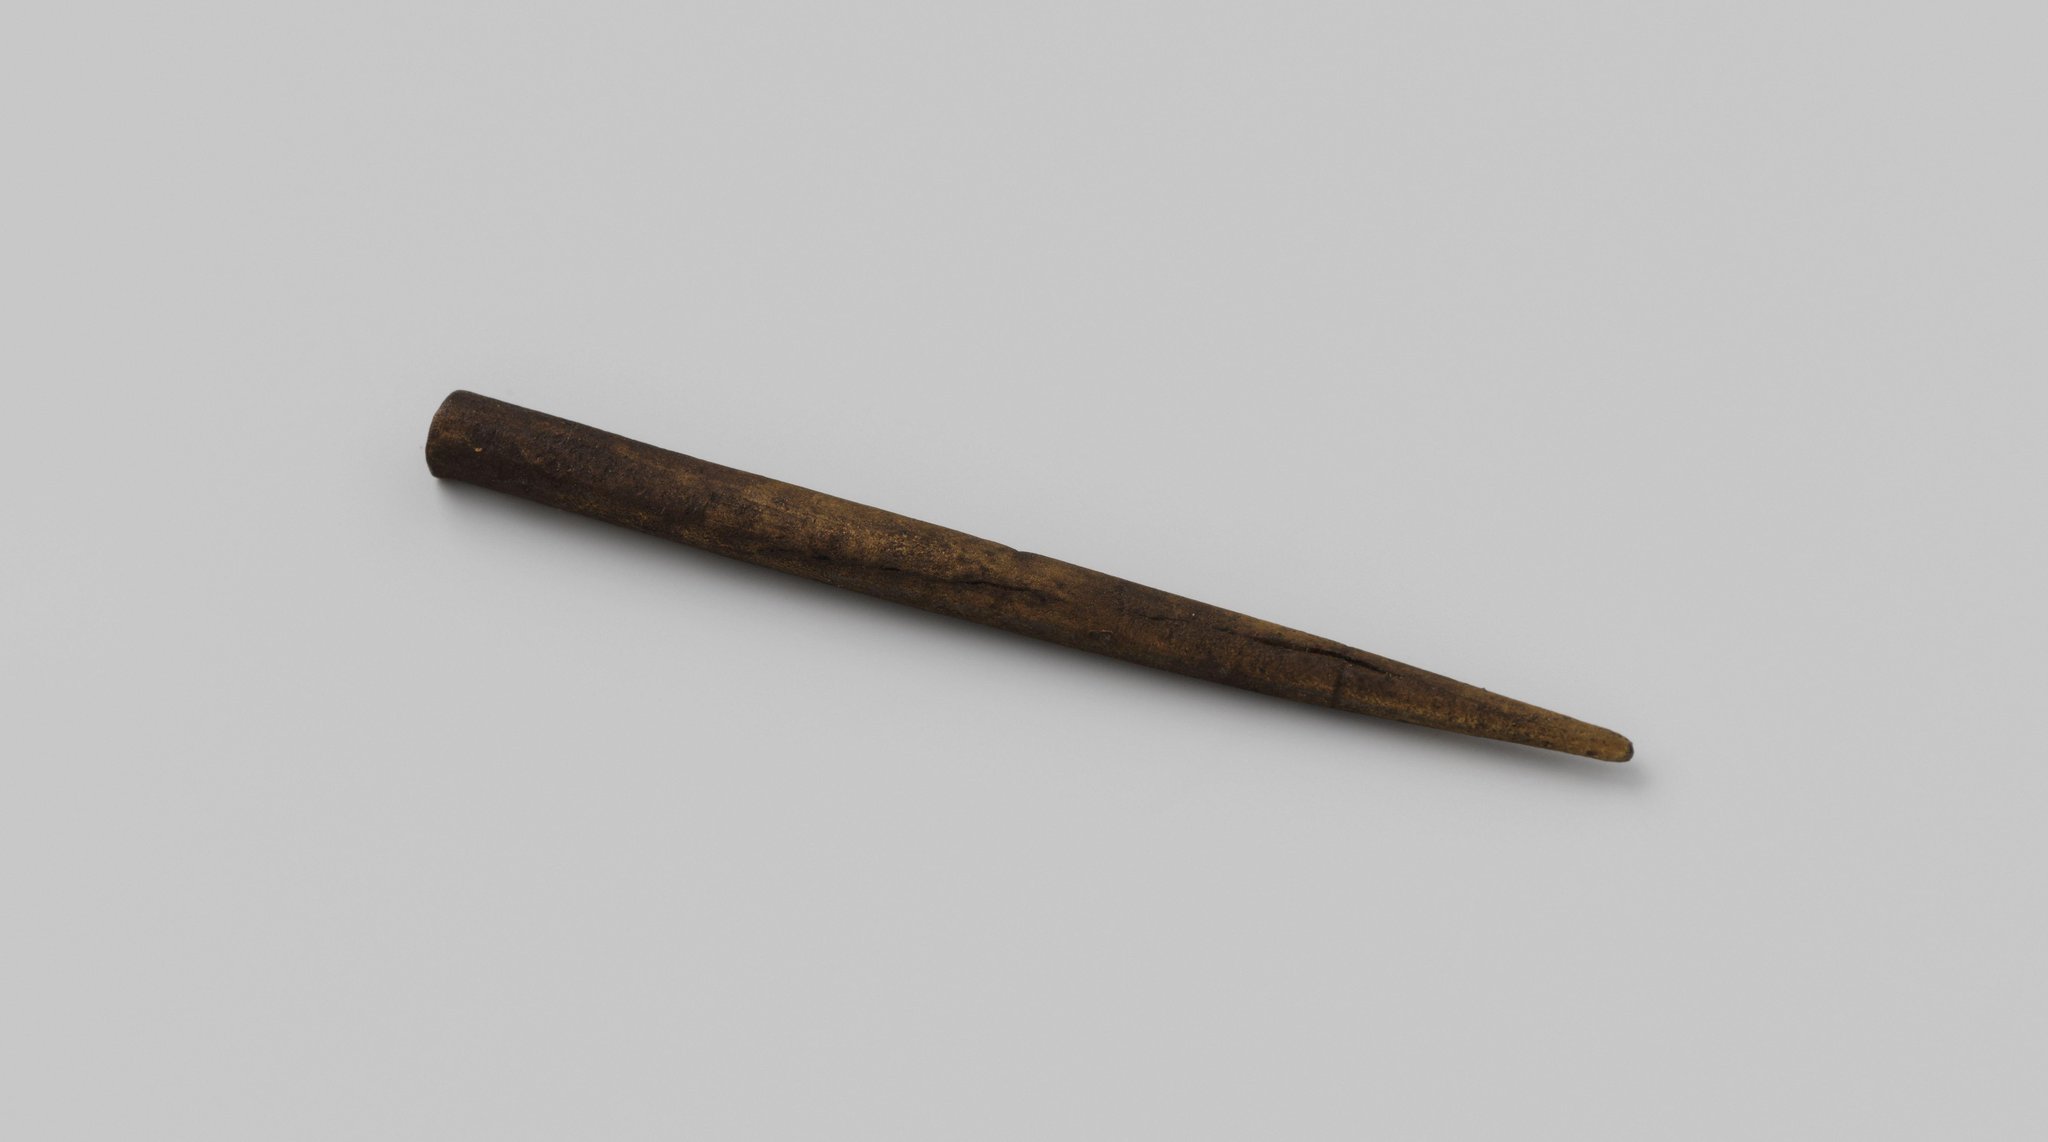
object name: fragment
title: Gepunt onderdeel uit het wrak van de Oost-Indiëvaarder Hollandia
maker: Anonymous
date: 1700-1743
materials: copper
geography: netherlands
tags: verenigde oostindische compagnie, hollandia (schip), annet